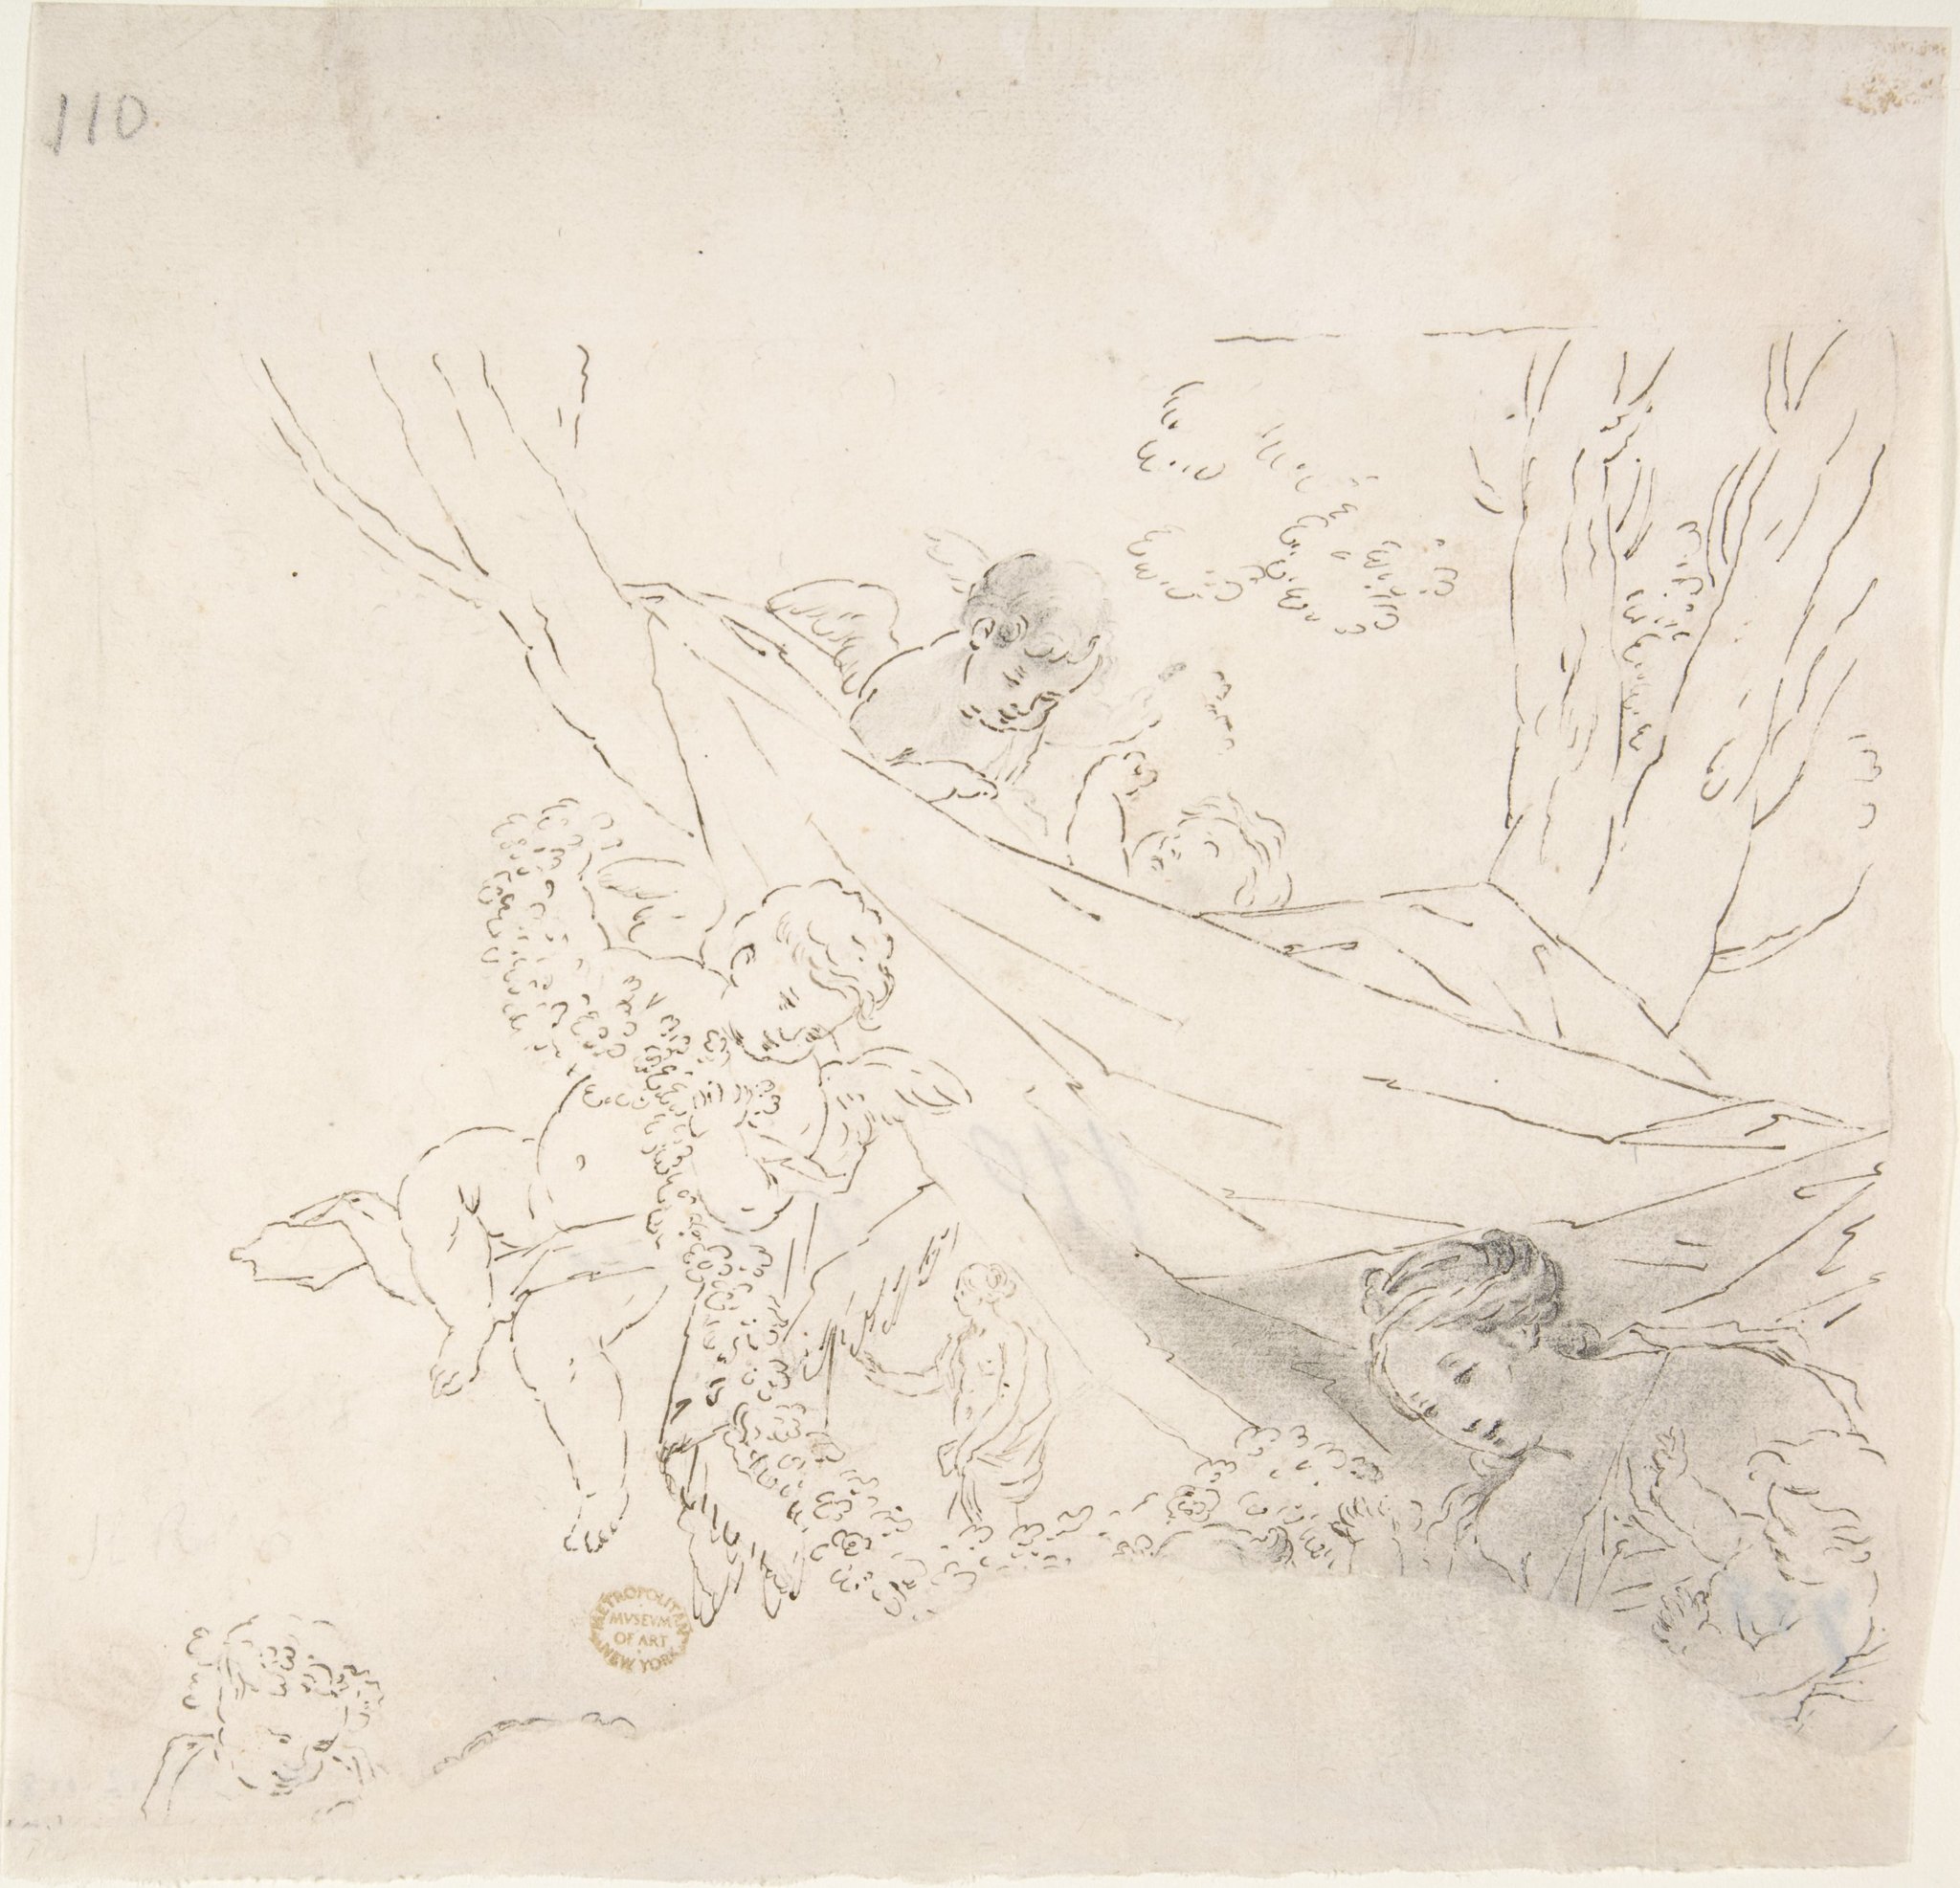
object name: drawing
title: Female Figure with Cherubs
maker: anonymous, italian, 18th century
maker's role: artist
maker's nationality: italian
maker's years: 1700-1800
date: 1701-1800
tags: women